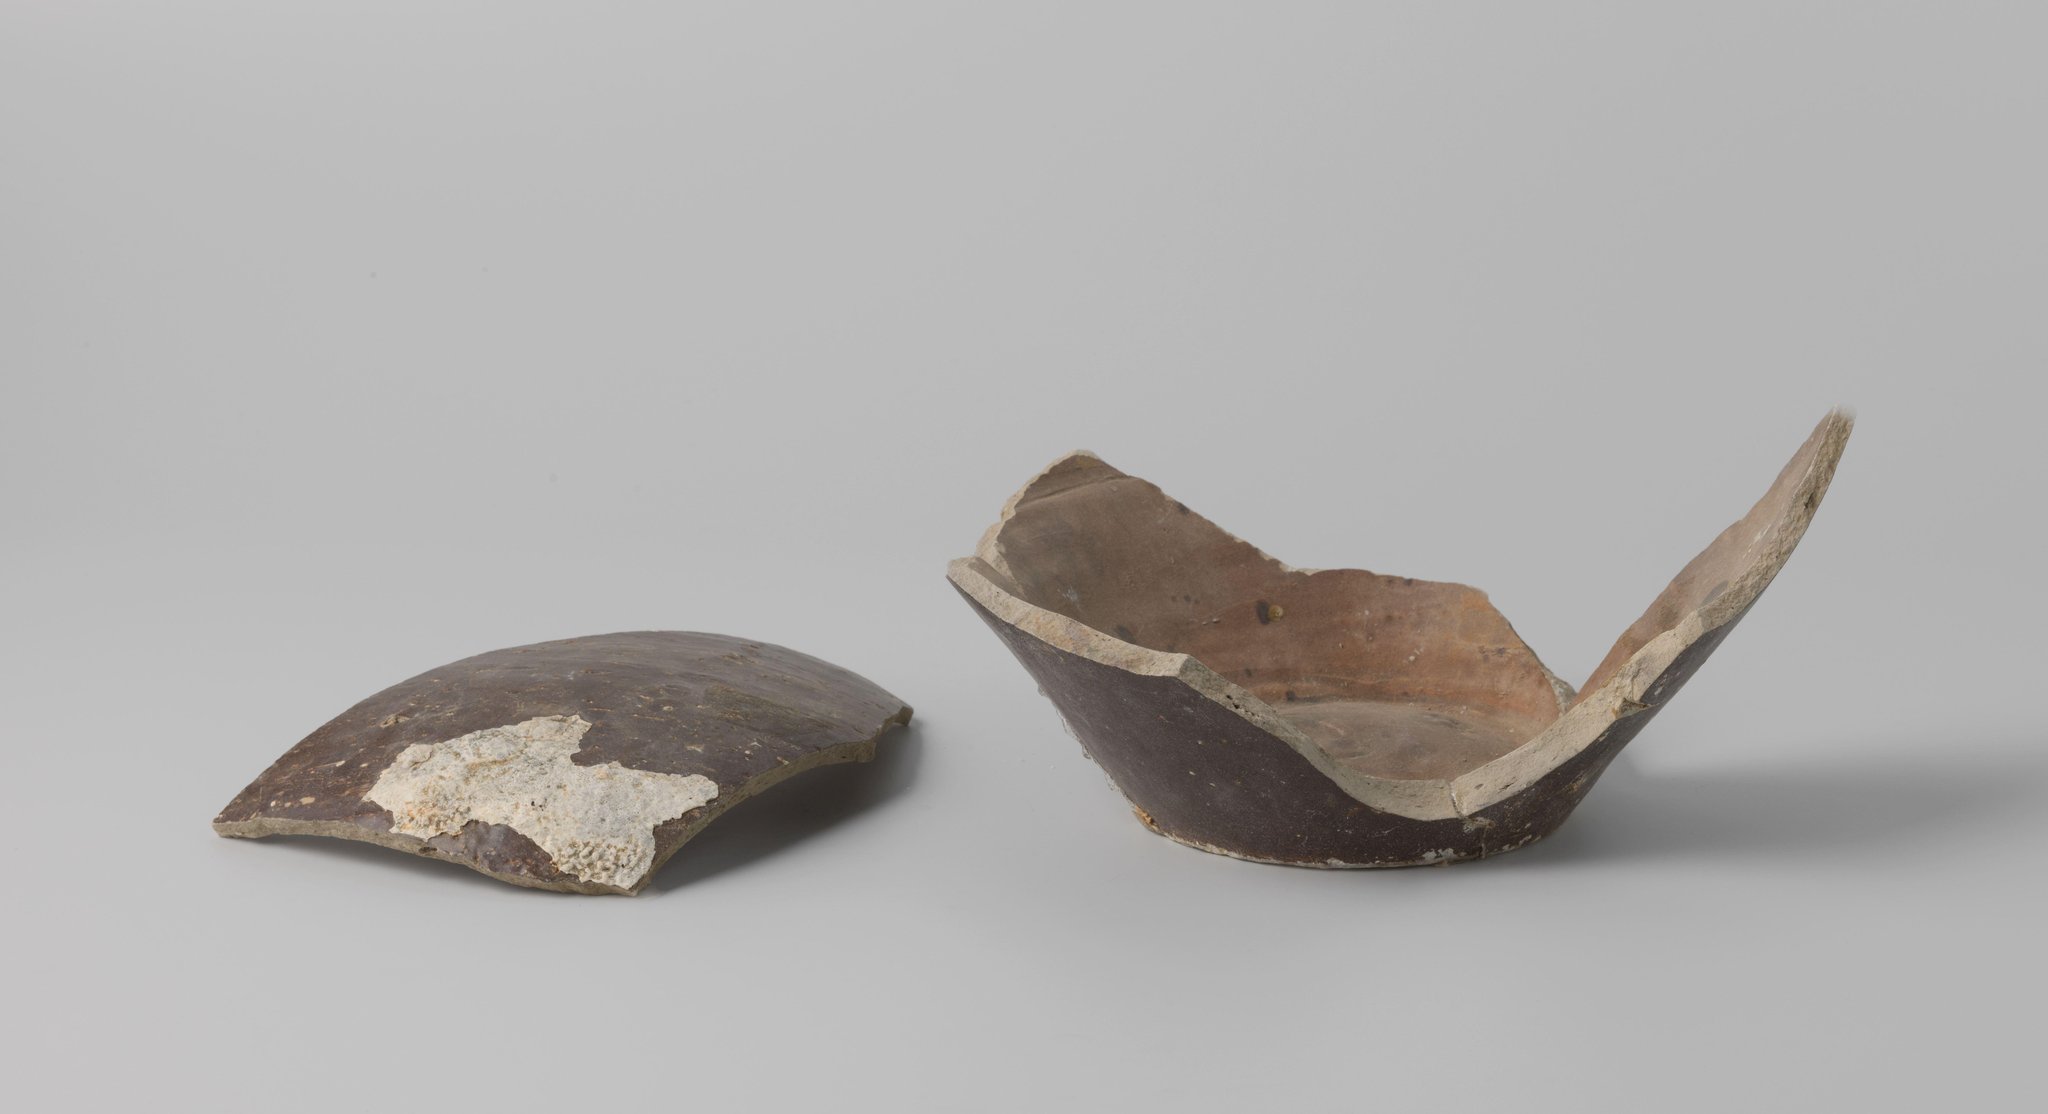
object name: martavaan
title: Scherf van een martavaan uit V.O.C.-schip de 'Witte Leeuw'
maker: Anonymous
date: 1613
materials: porcelain, stoneware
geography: southeast asia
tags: verenigde oostindische compagnie, sint-helena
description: A jar. This exceptional jar has a wide waist and narrows towards the neck which ends in a narrow flaring mouth. The thin, double walled base has bursted open. The grey coloured clay contains few impurities. There are no traces of glaze on the outside or inside. It ha possibly been covered with a glaze or a slip. The upper half of the exterior has concentric grooves neatly incised from the neck to the waist.